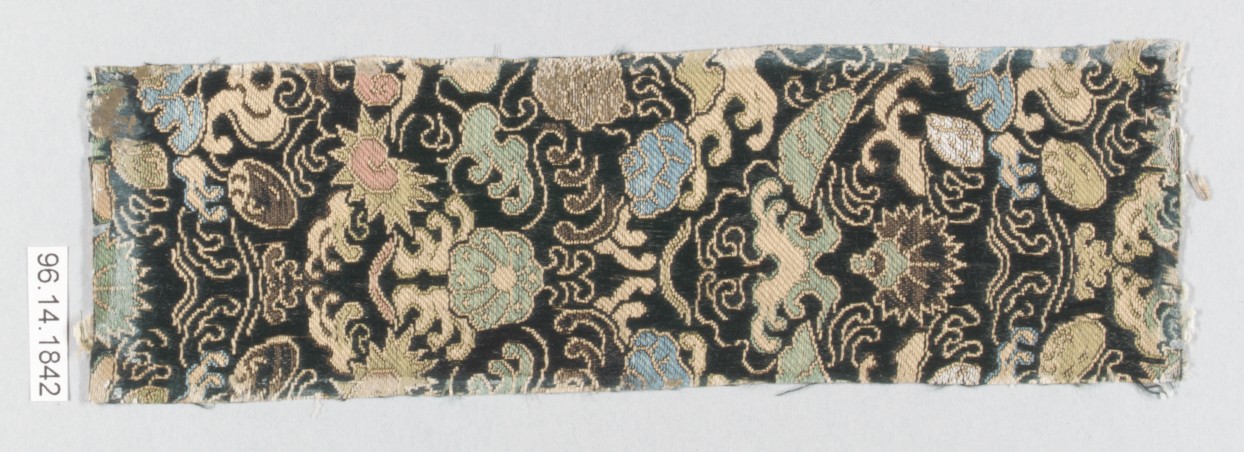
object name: piece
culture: japanese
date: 1701-1900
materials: silk